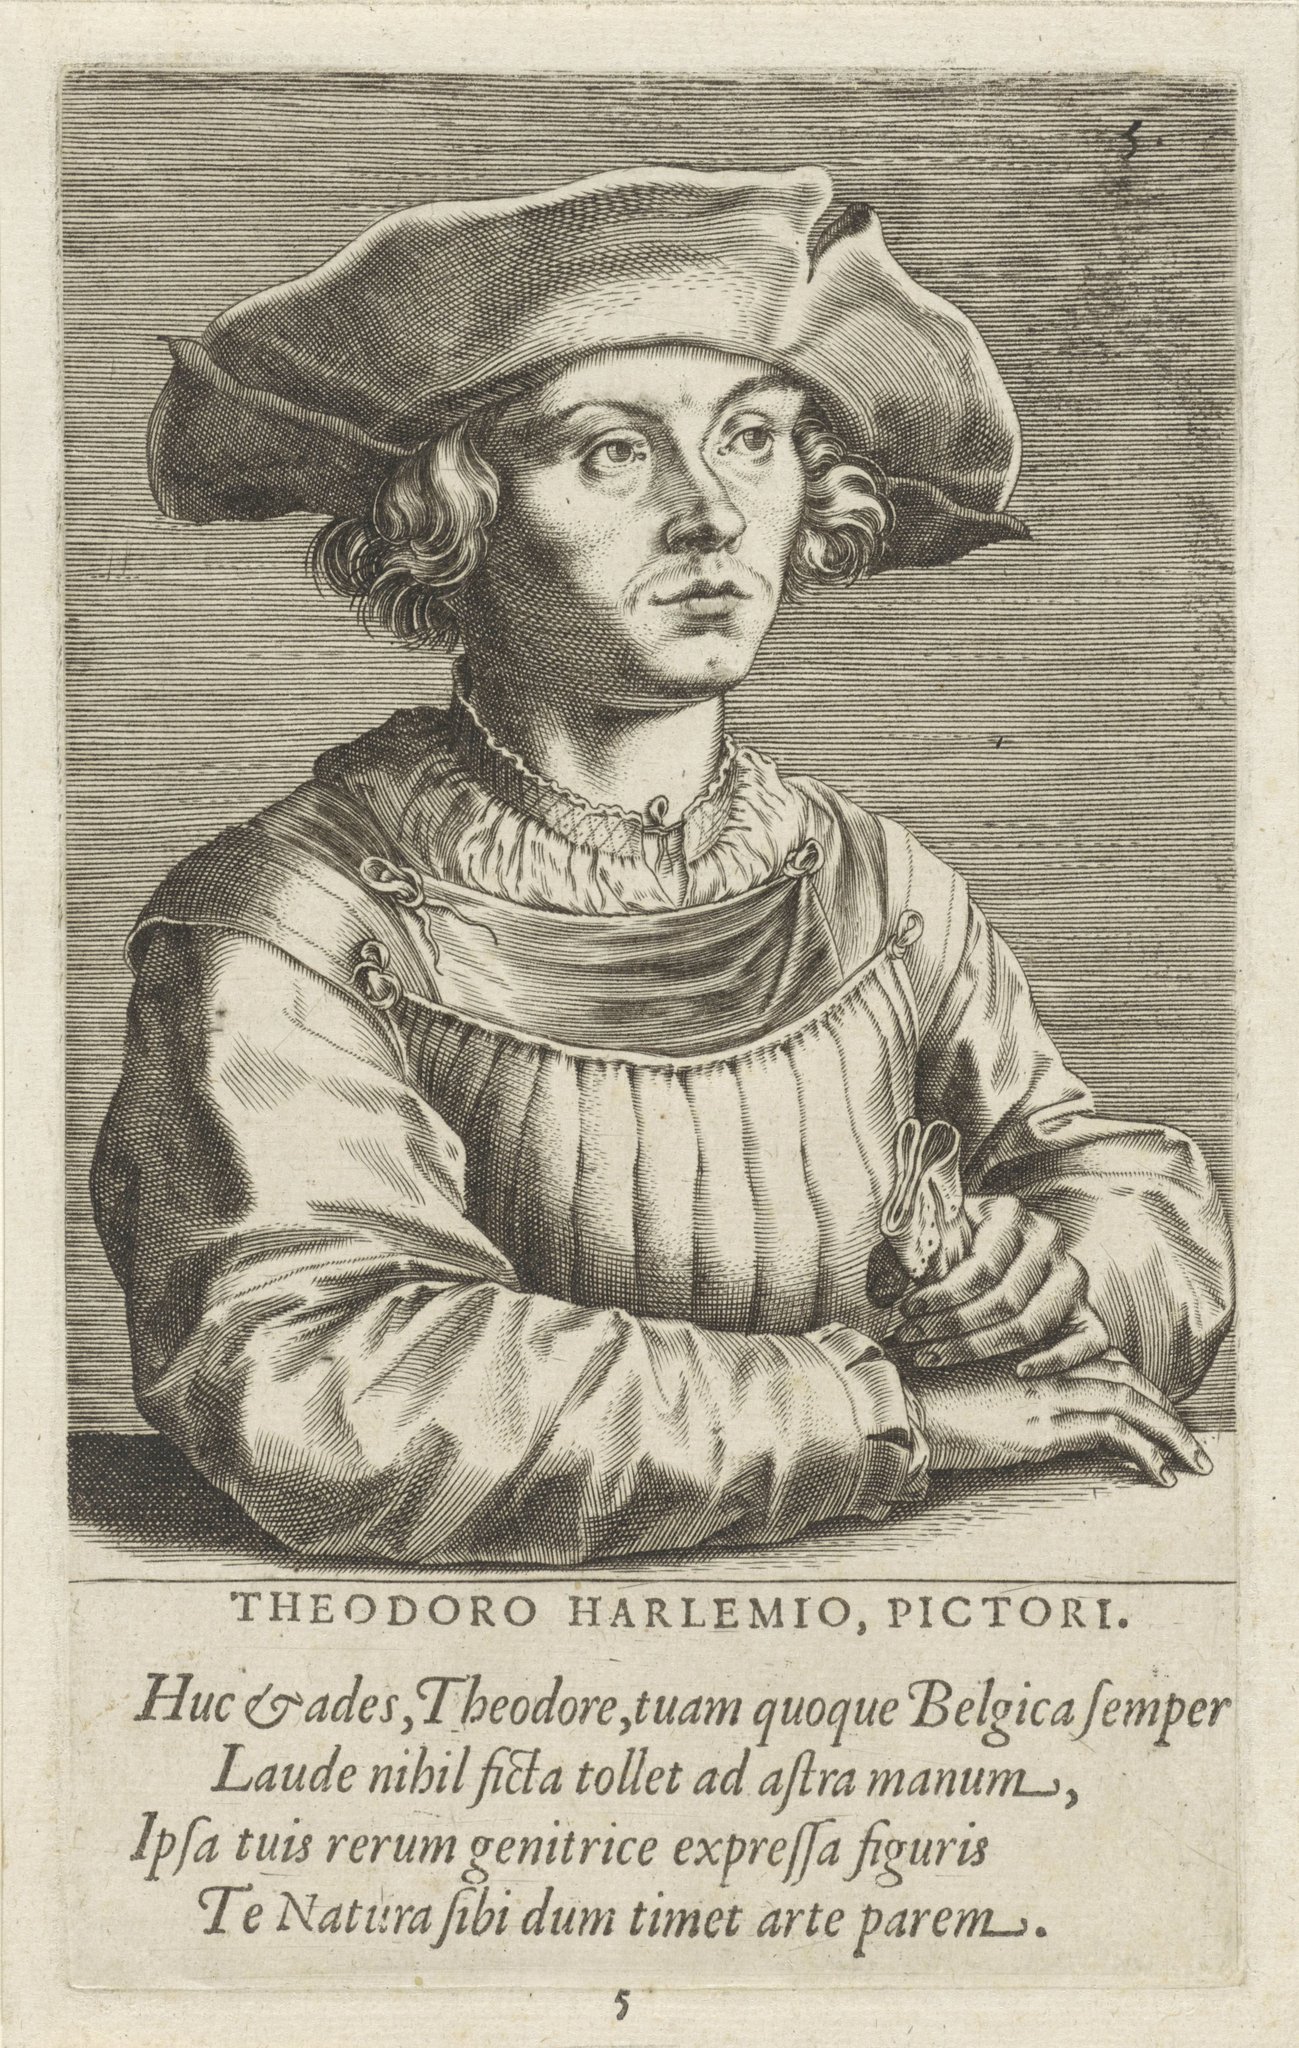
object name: print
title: Portretten van schilders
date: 1572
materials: paper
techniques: engraving, letterpress printing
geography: antwerp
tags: brussels, painter, draughtsman, bernard van orley, portrait, self-portrait of painter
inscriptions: collector's mark: Lugt 2228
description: In de marge een vierregelig onderschrift in het Latijn.